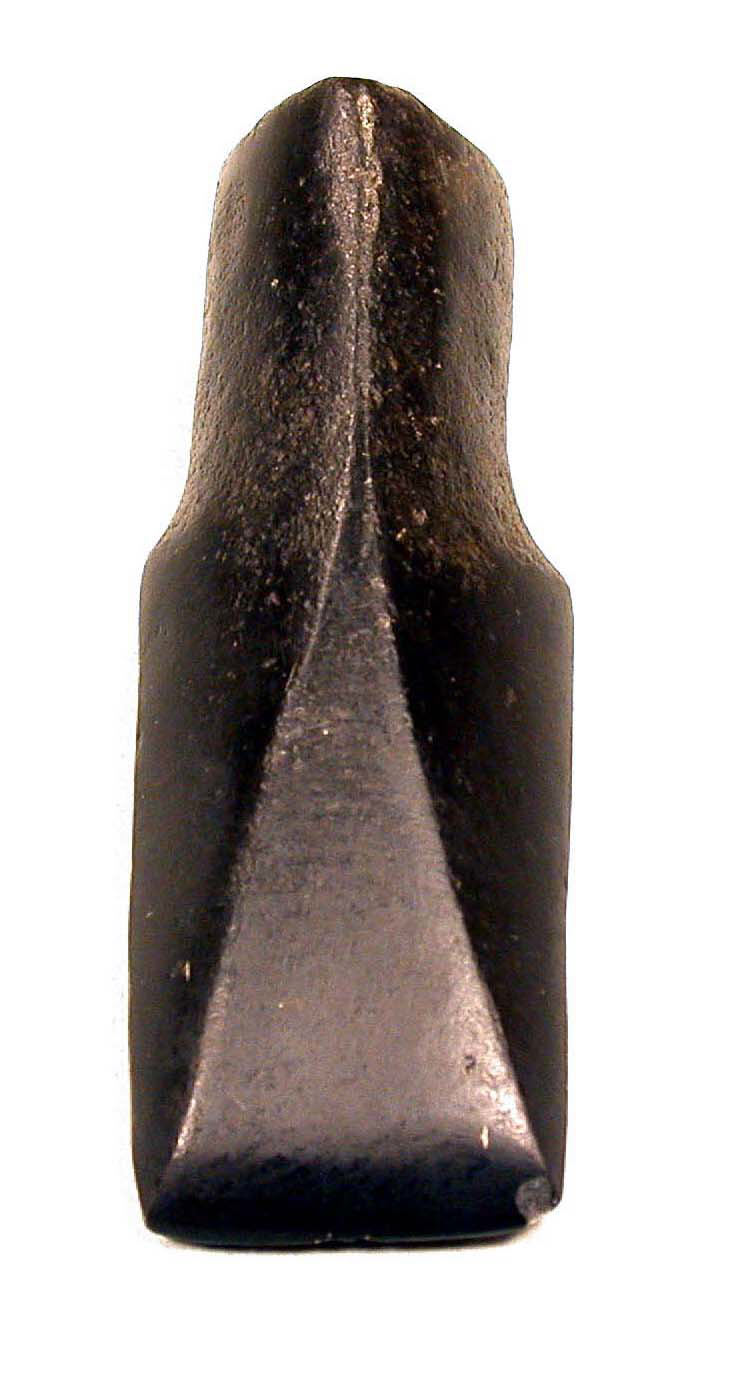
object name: adze blade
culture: cook islands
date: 1801-1900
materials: stone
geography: cook islands